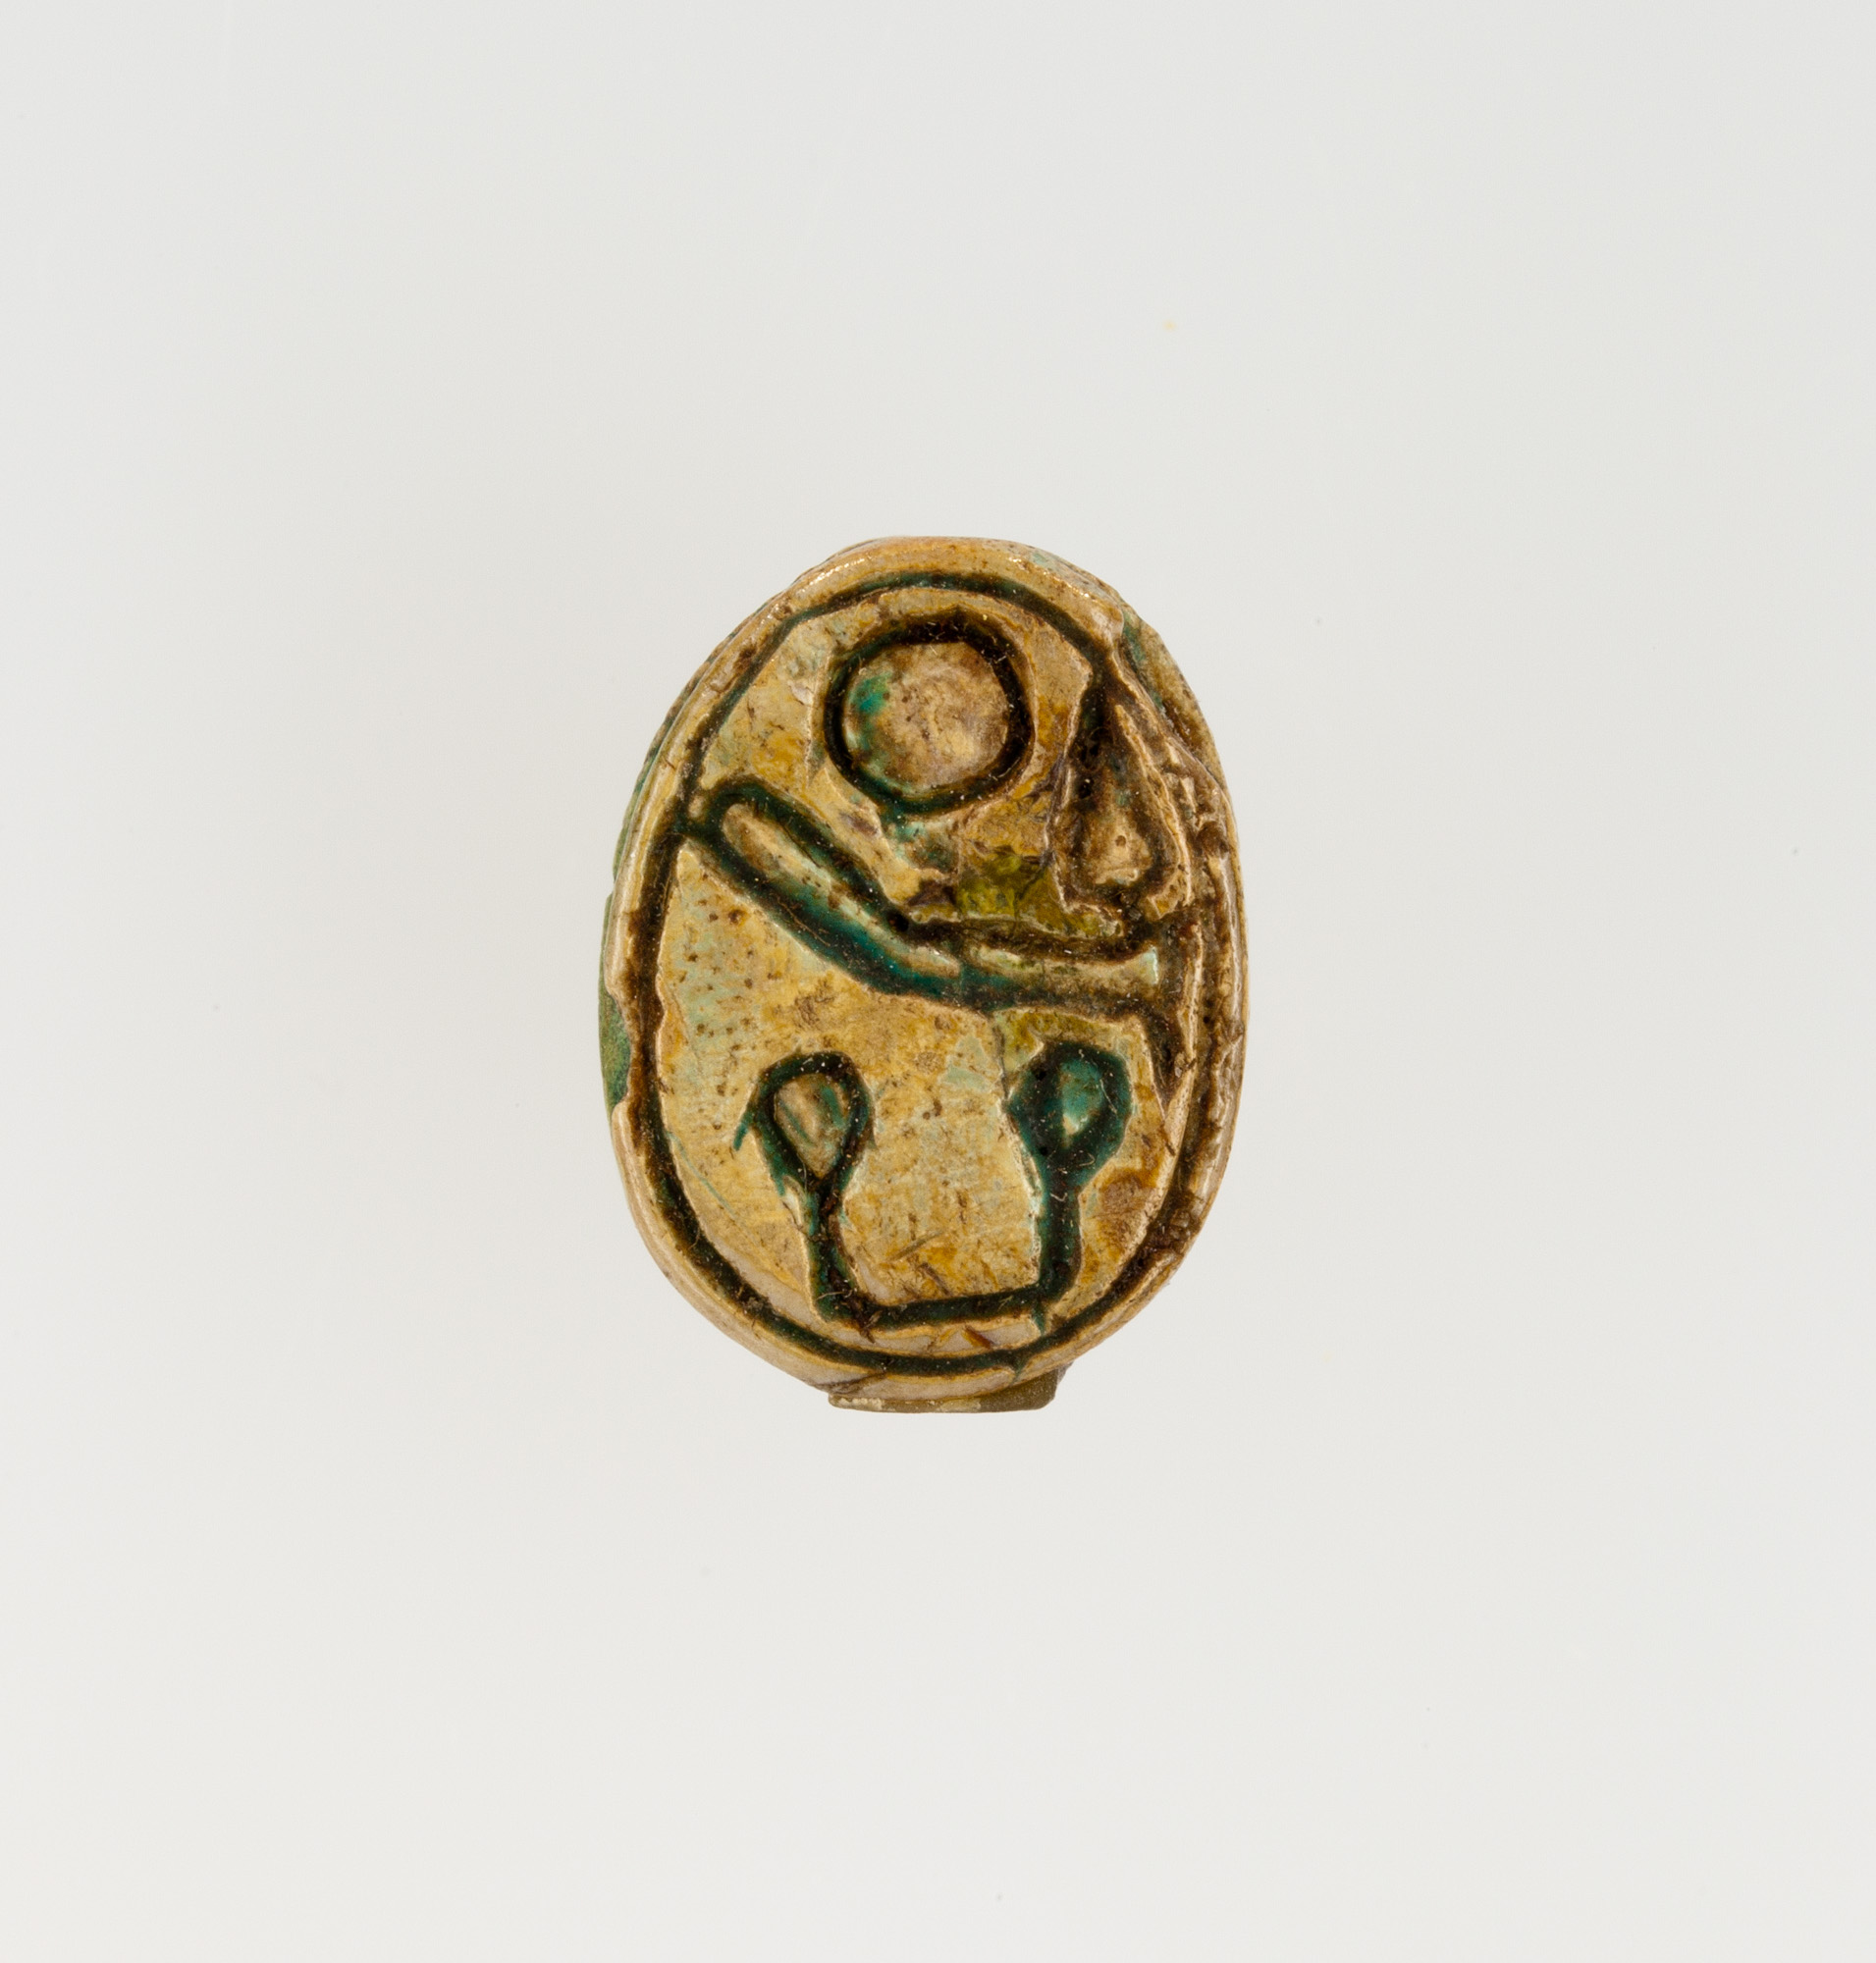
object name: scarab, amenhotep i, djeserkare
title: Scarab Inscribed with the Throne Name of Amtenhotep I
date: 1525-1504 BCE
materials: stone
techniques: glazing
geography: egypt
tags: scarabs